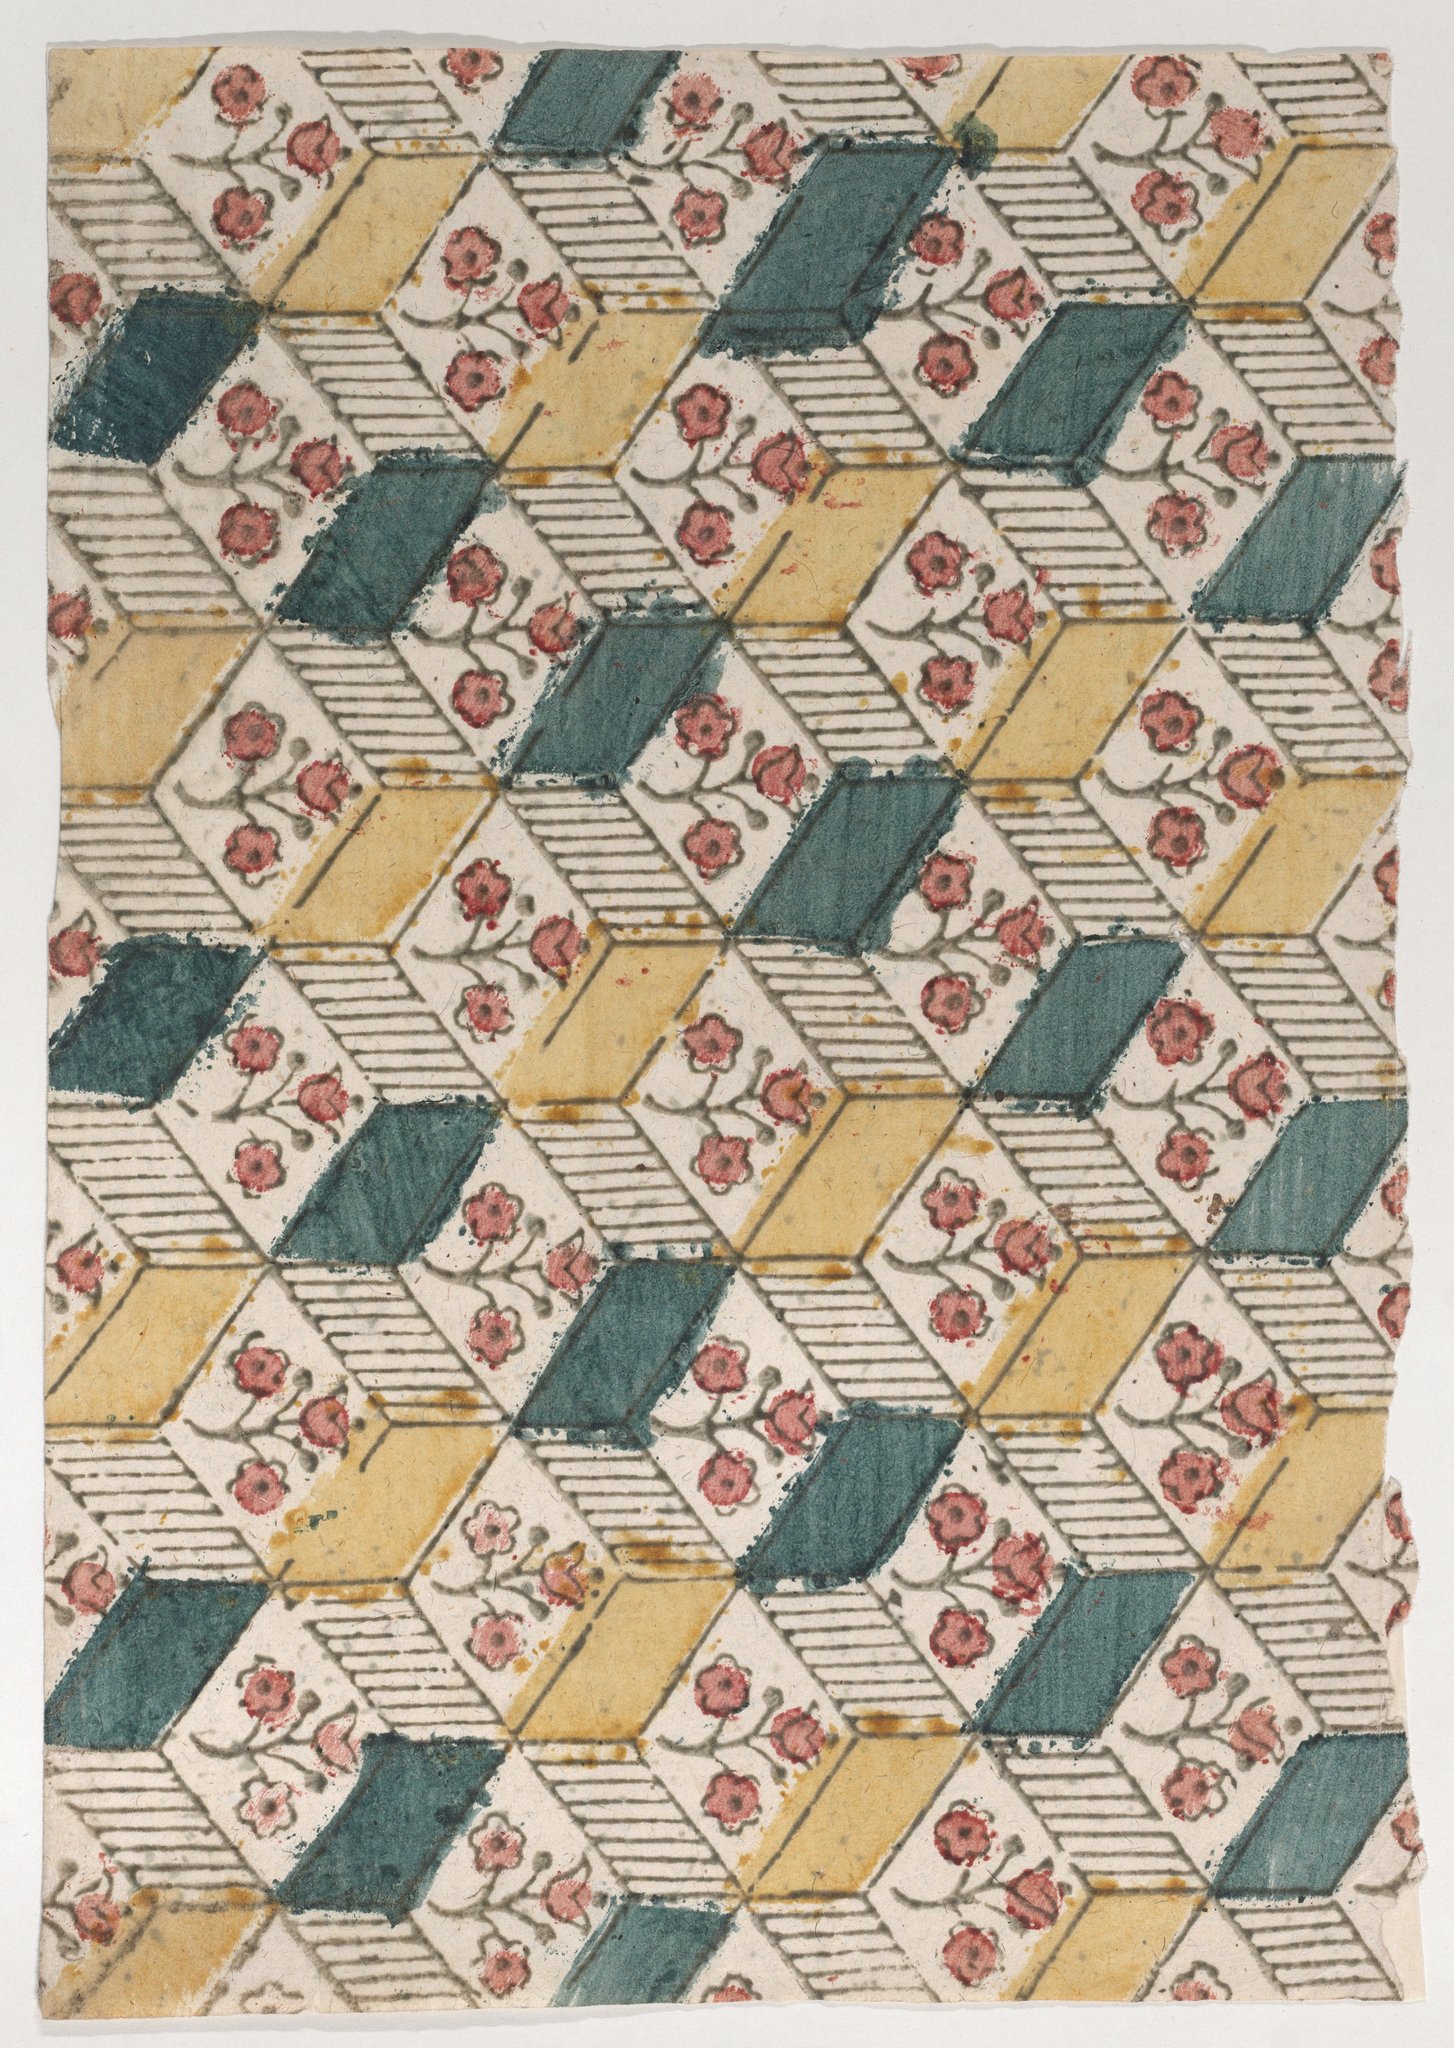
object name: print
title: Sheet with an overall floral and geometric pattern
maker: Anonymous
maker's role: artist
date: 1801-1900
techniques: relief print